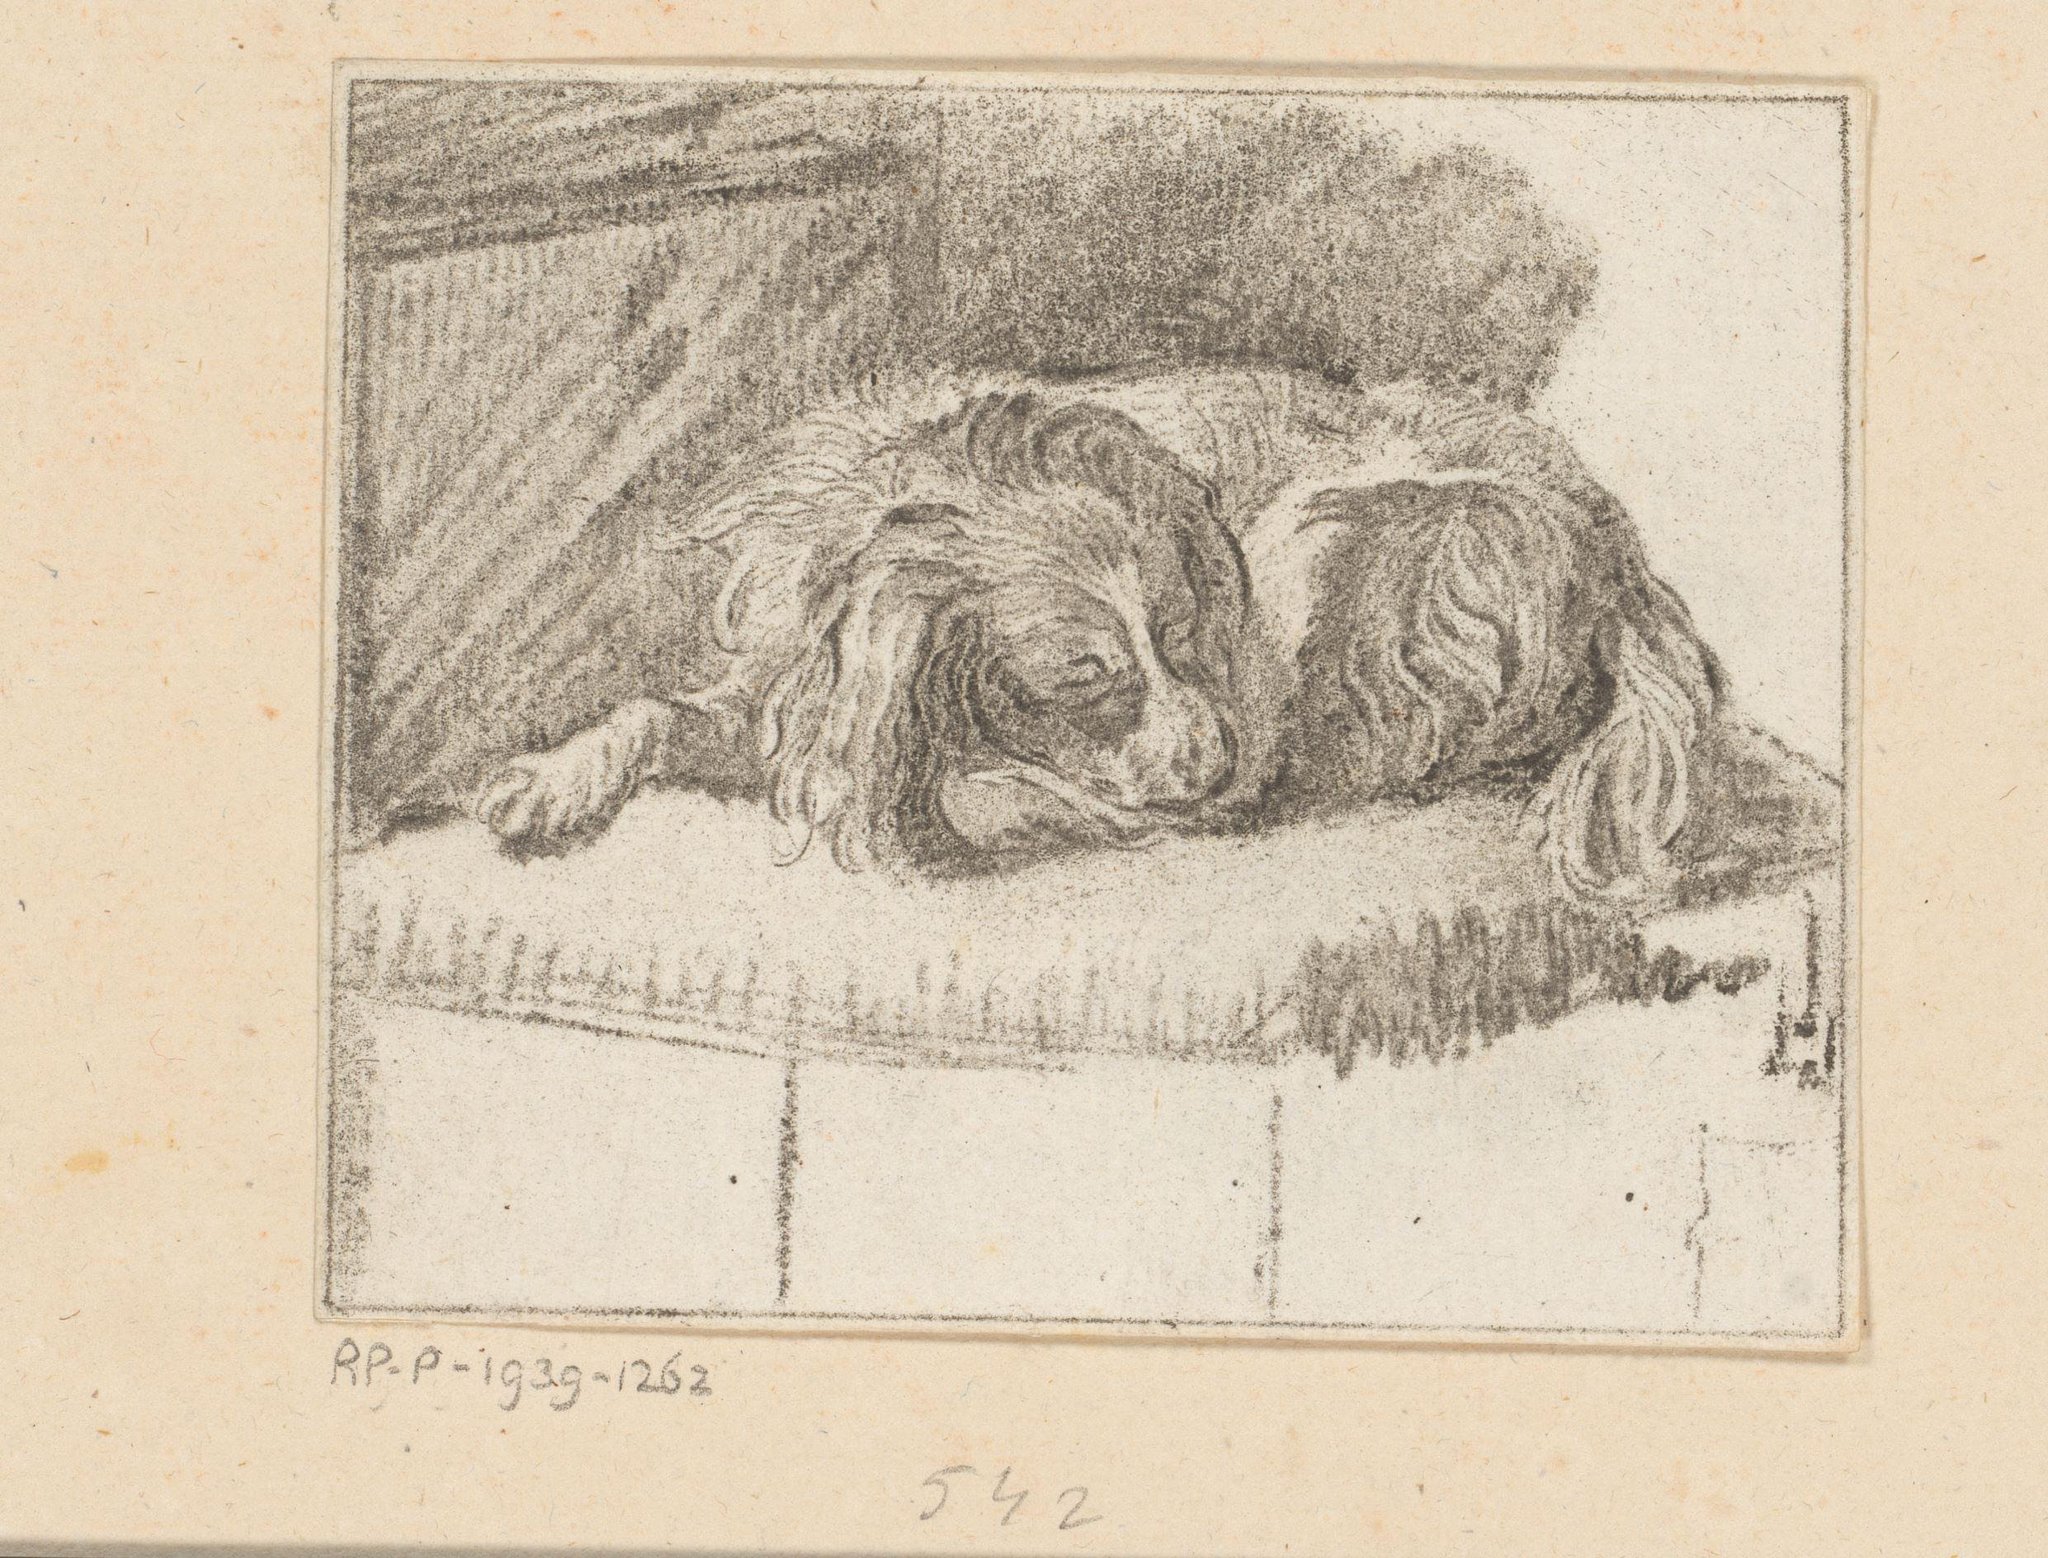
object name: print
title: Liggende hond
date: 1777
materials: paper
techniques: printmaking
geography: amsterdam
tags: dog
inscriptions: collector's mark: ‘RIJKS / MUSM’, collector's mark: Lugt 2725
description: De prent ligt los in het album, zie blad 27.